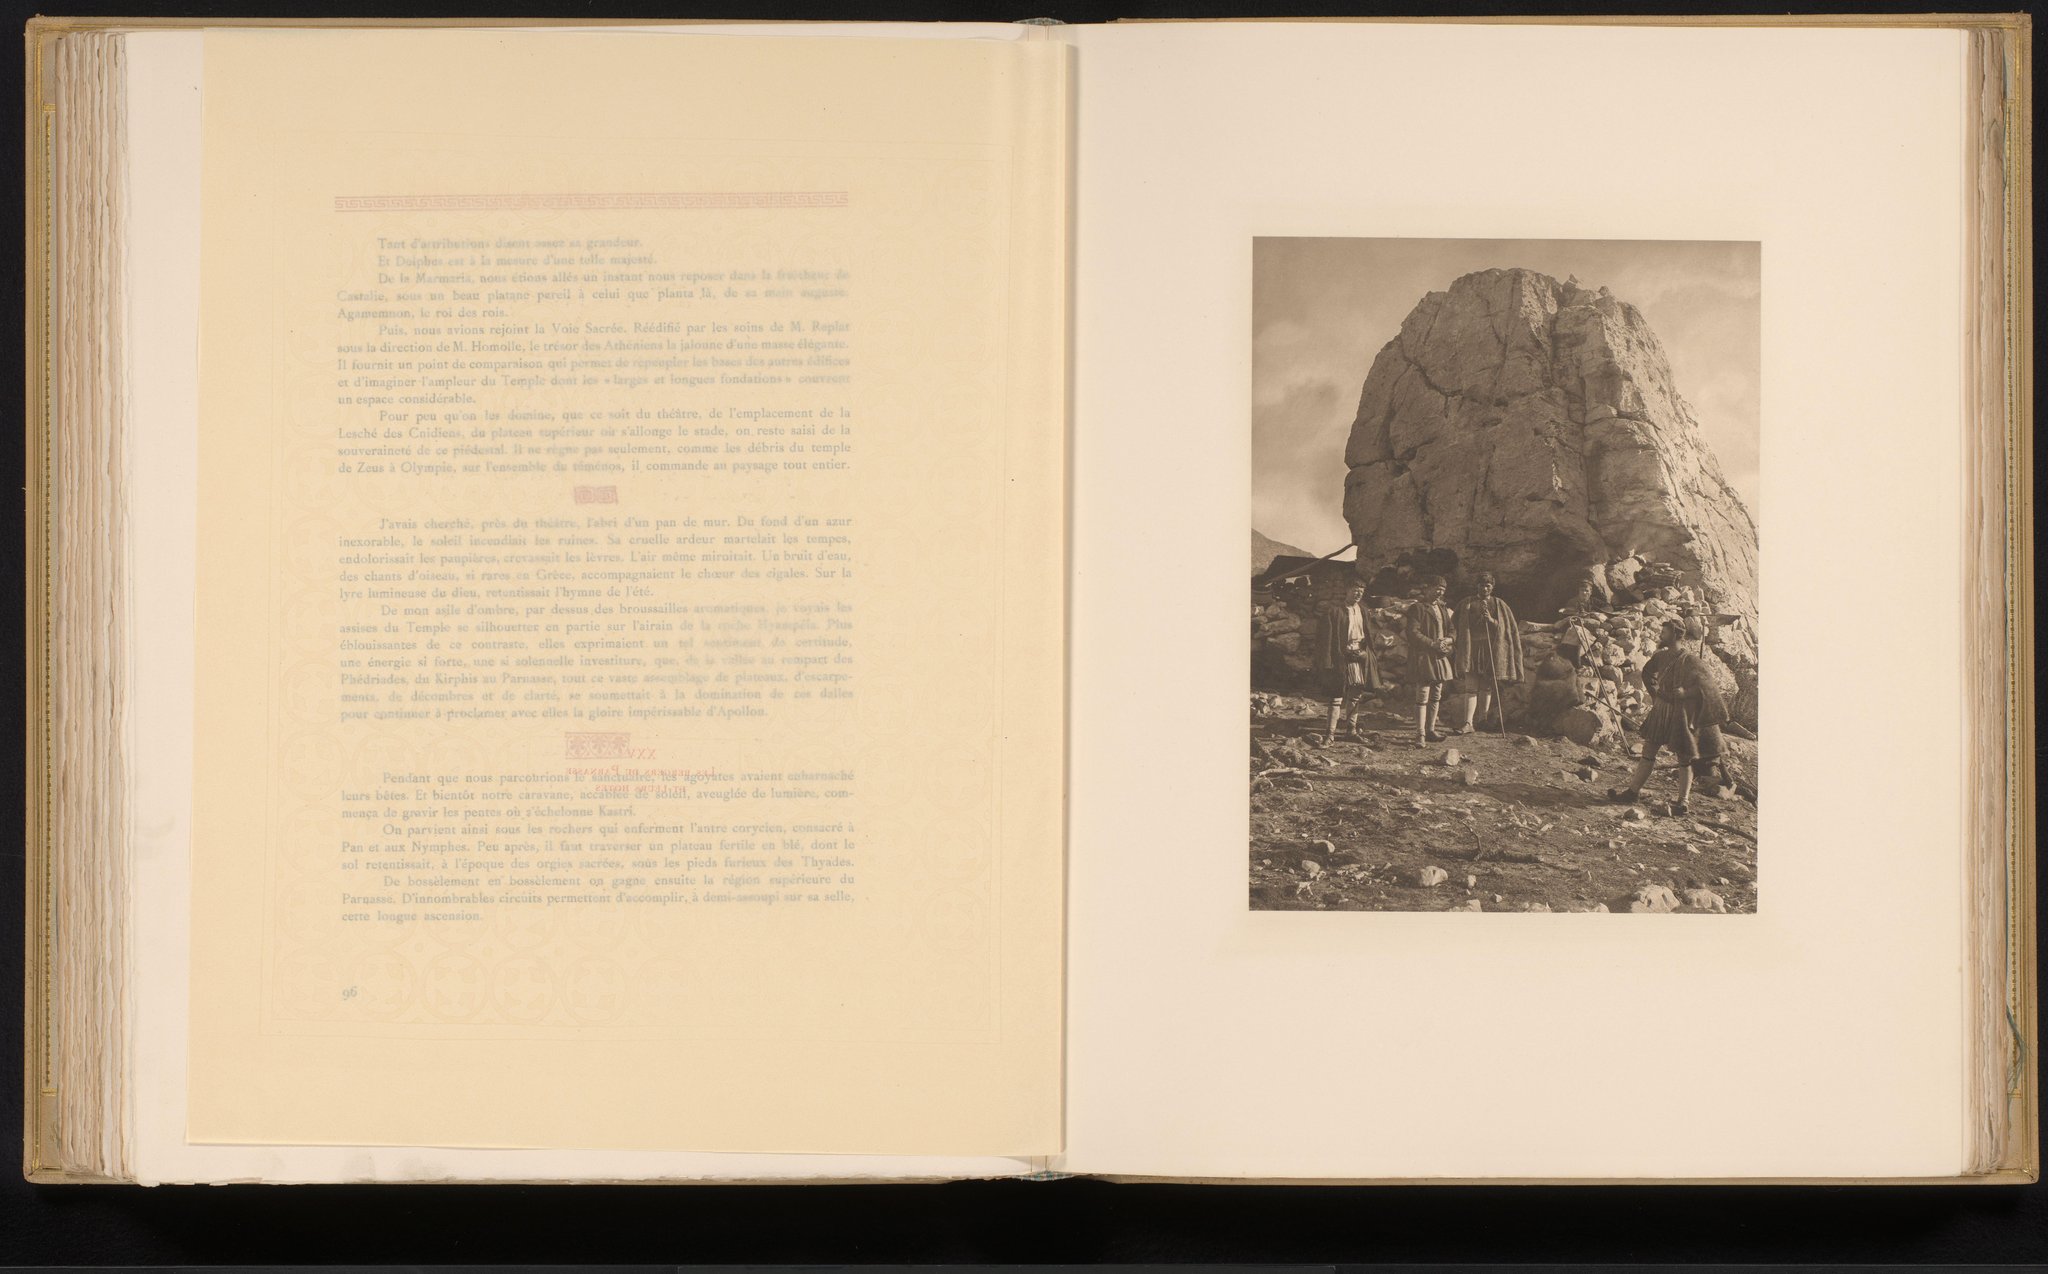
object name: photomechanical print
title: Herders op de Parnassus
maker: frédéric boissonnas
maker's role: fotograaf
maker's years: 1858-1946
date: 1905-1910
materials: paper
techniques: photoaquatint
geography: berlin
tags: herding, herdsman, herdswoman, shepherd, shepherdess, cowherd, etc.